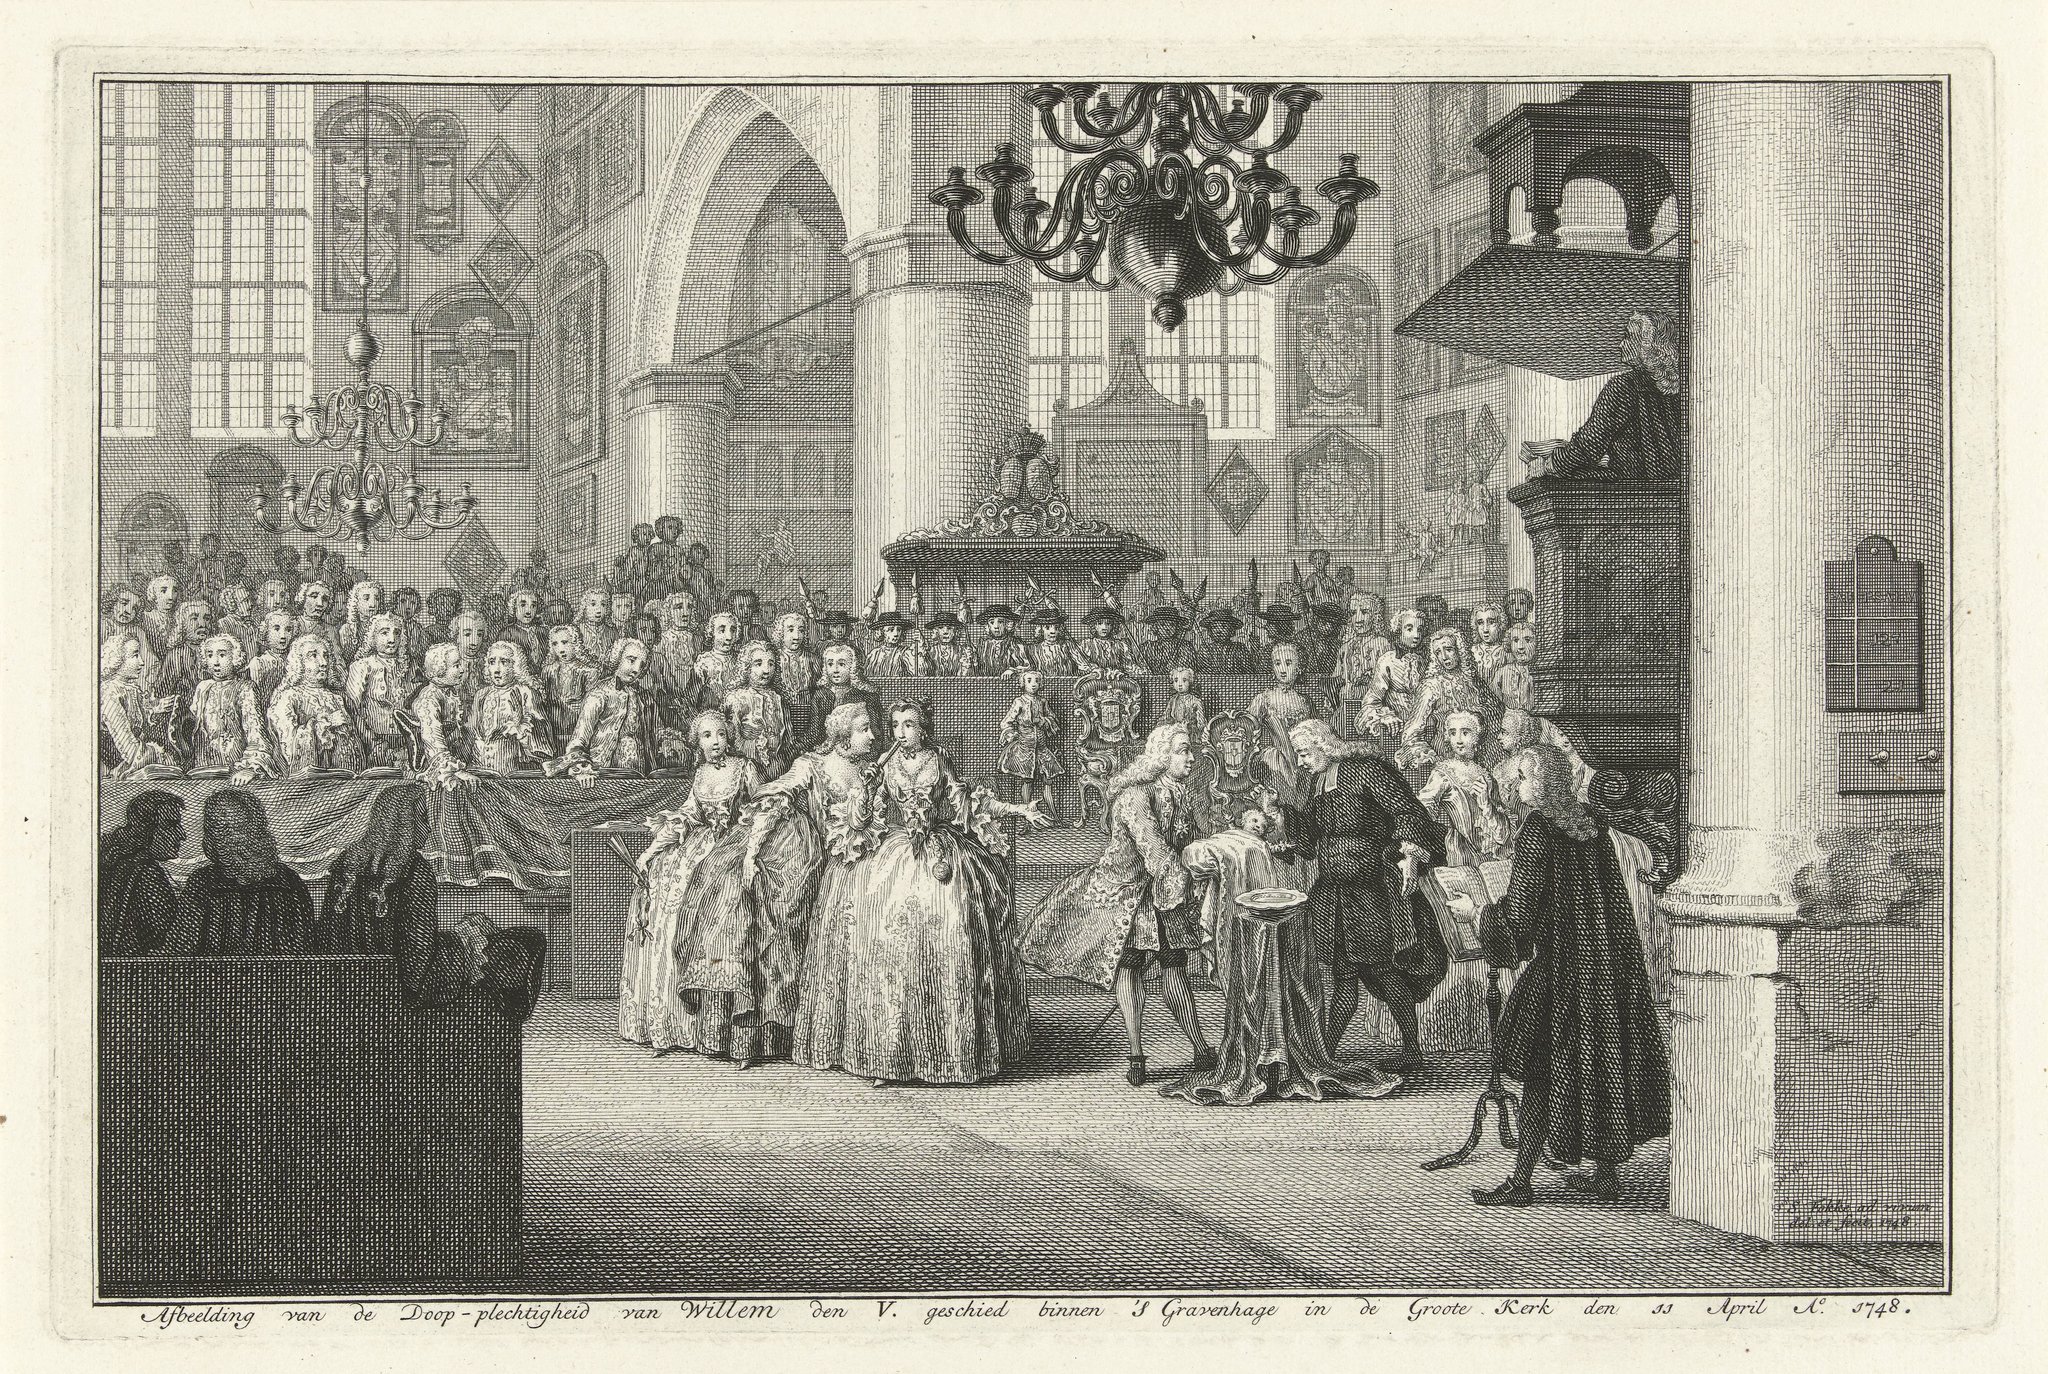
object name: print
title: Afbeelding van de doop-plechtigheid van Willem den V. geschied binnen 's Gravenhage in de Groote Kerk den 11 april Ao. 1748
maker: simon fokke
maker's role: draughtsman, print maker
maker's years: 1712-1784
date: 1748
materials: paper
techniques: engraving, etching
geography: amsterdam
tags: the hague, william v (prince of orange), willem iv (prins van oranje-nassau), anna van hannover, baptism ~ protestant service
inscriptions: collector's mark: Lugt 2228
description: Doopceremonie van prins Willem V in de Grote Kerk te Den Haag, 11 april 1748. Willem IV houdt het kind tijdens het dopen vast, links kijkt de prinses met hofdames toe. Kerkinterieur met vele gasten.